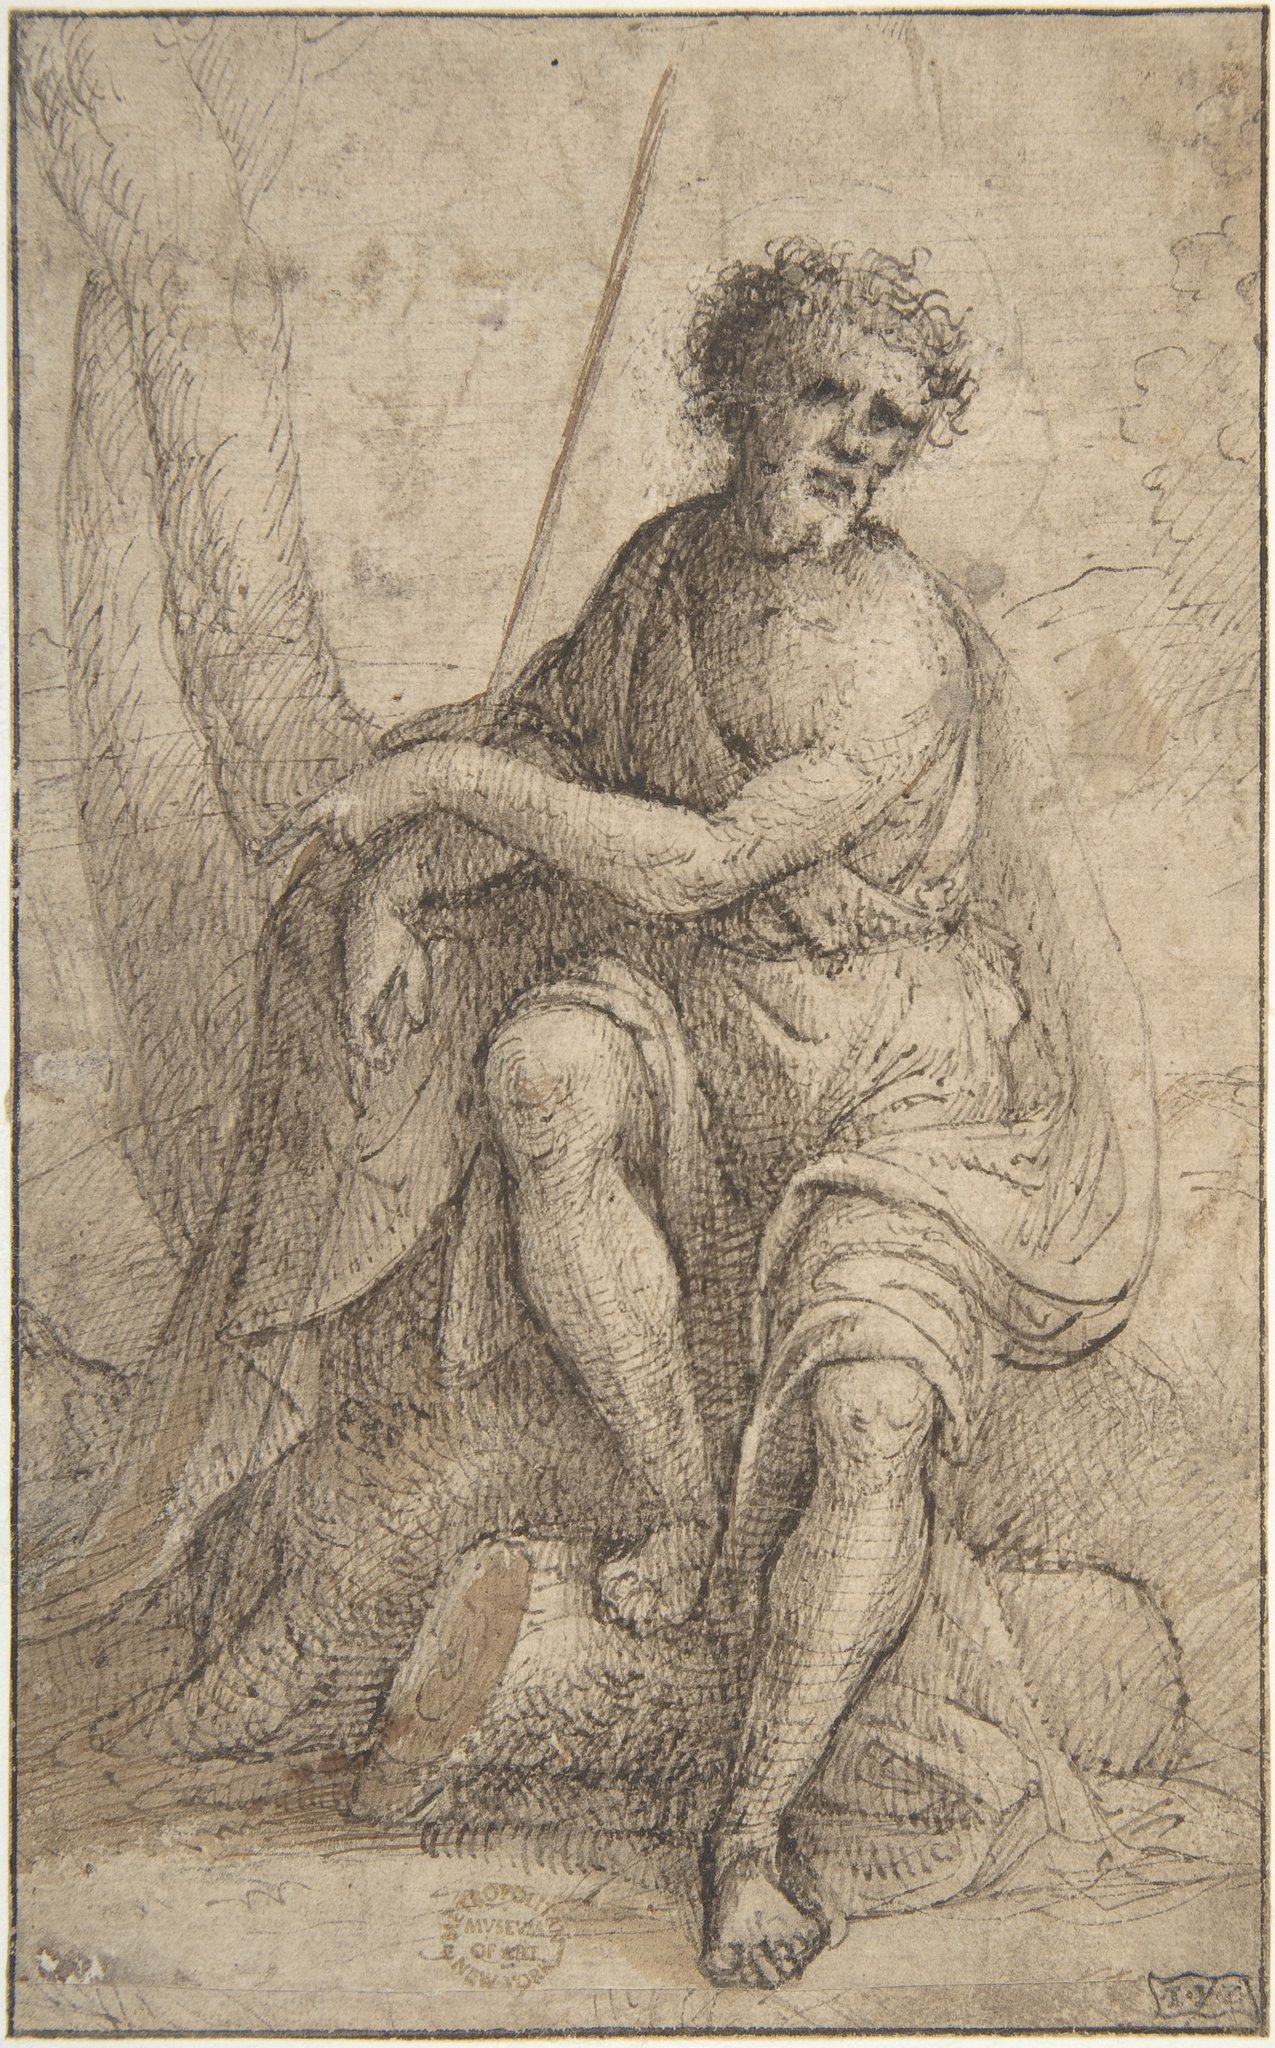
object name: drawing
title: Saint John the Baptist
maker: anonymous, italian, north italy, 16th century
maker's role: artist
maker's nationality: italian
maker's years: 1500-1600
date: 1550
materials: chalk, ink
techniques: brush, incising, pen, wash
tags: saint john the baptist